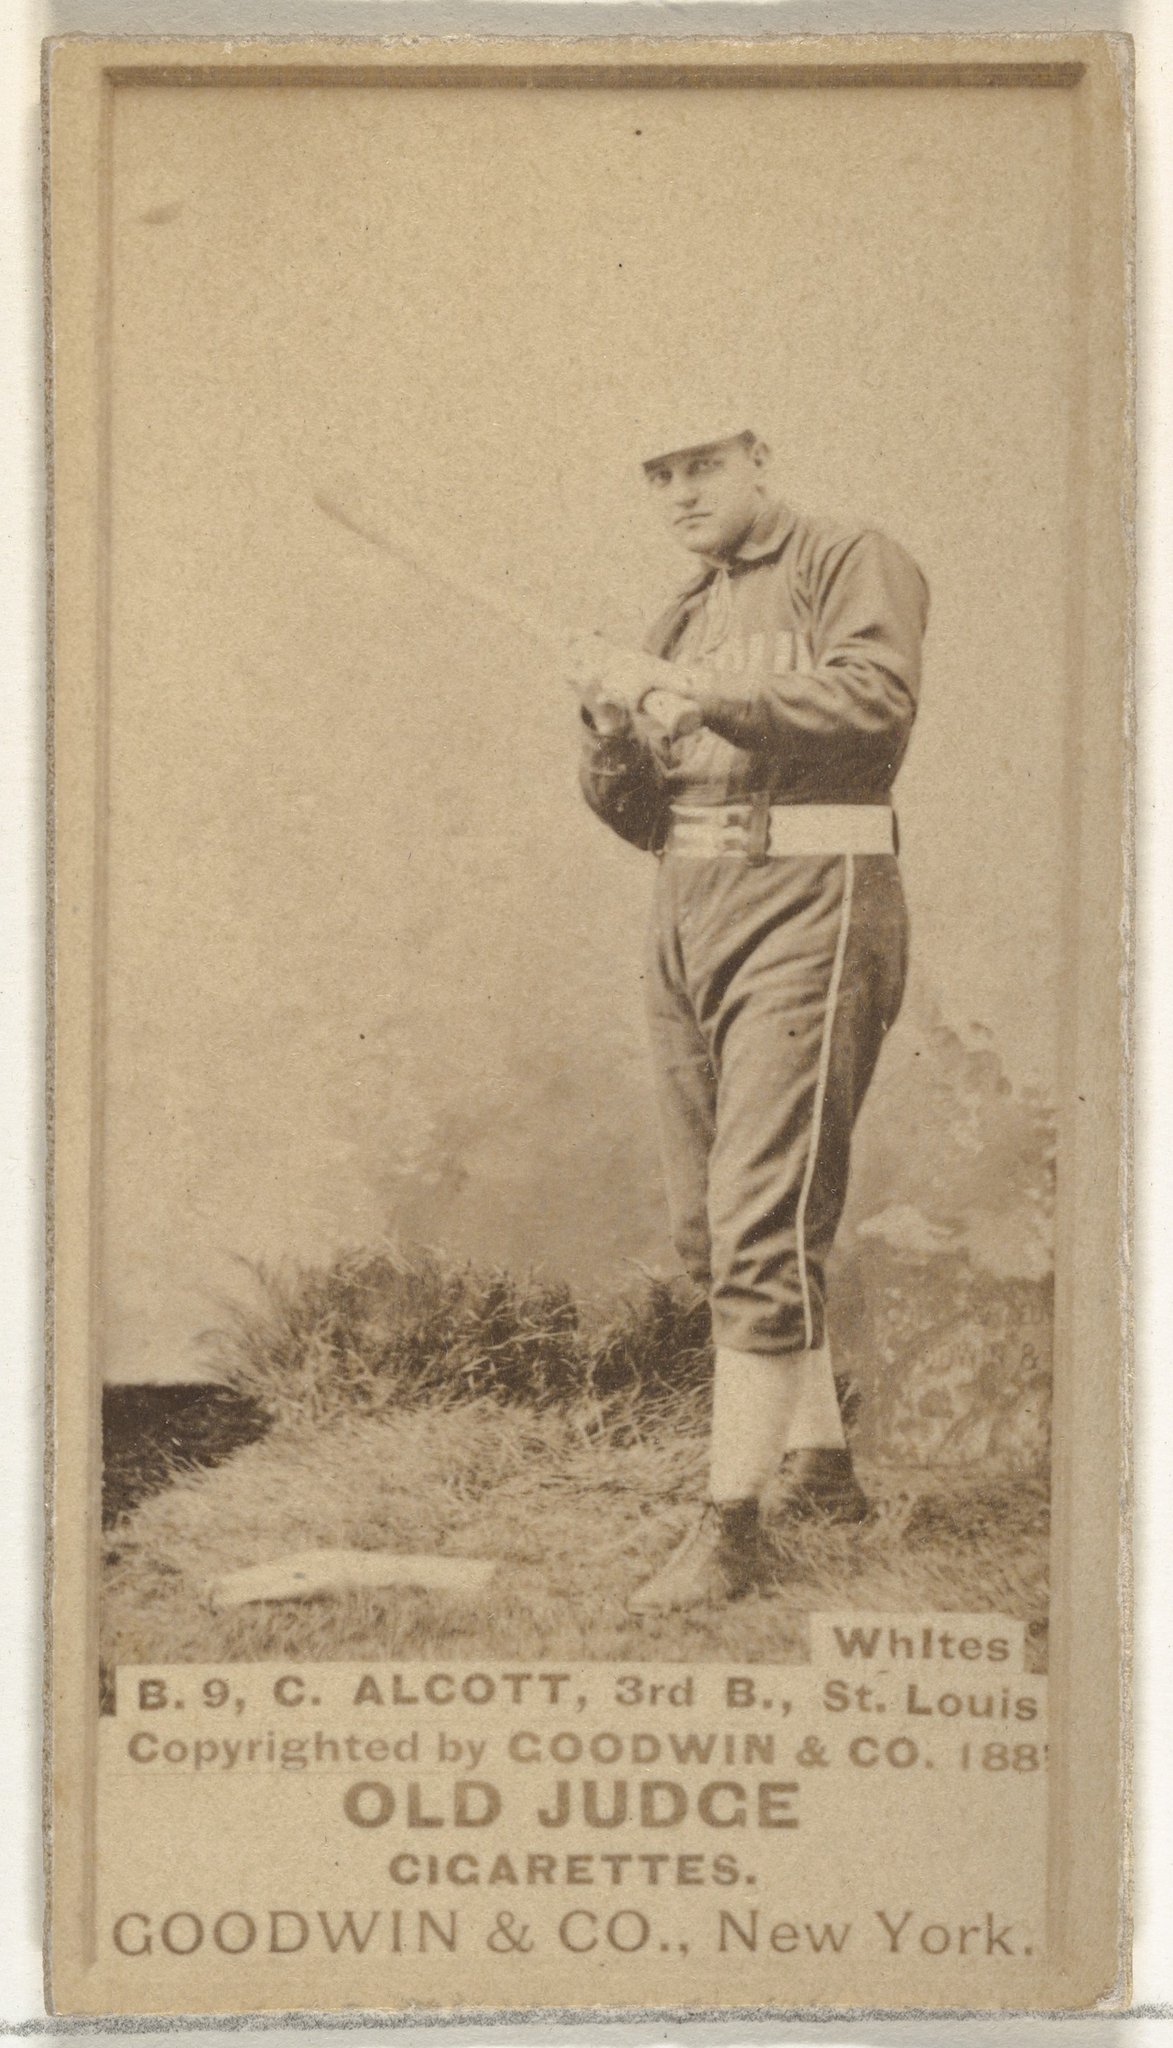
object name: baseball card, photograph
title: Alcott, 3rd Base, St. Louis Whites, from the Old Judge series (N172) for Old Judge Cigarettes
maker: goodwin & company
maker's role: publisher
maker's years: 1850-1950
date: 1888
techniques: albumen silver print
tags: men,portraits,baseball,athletes